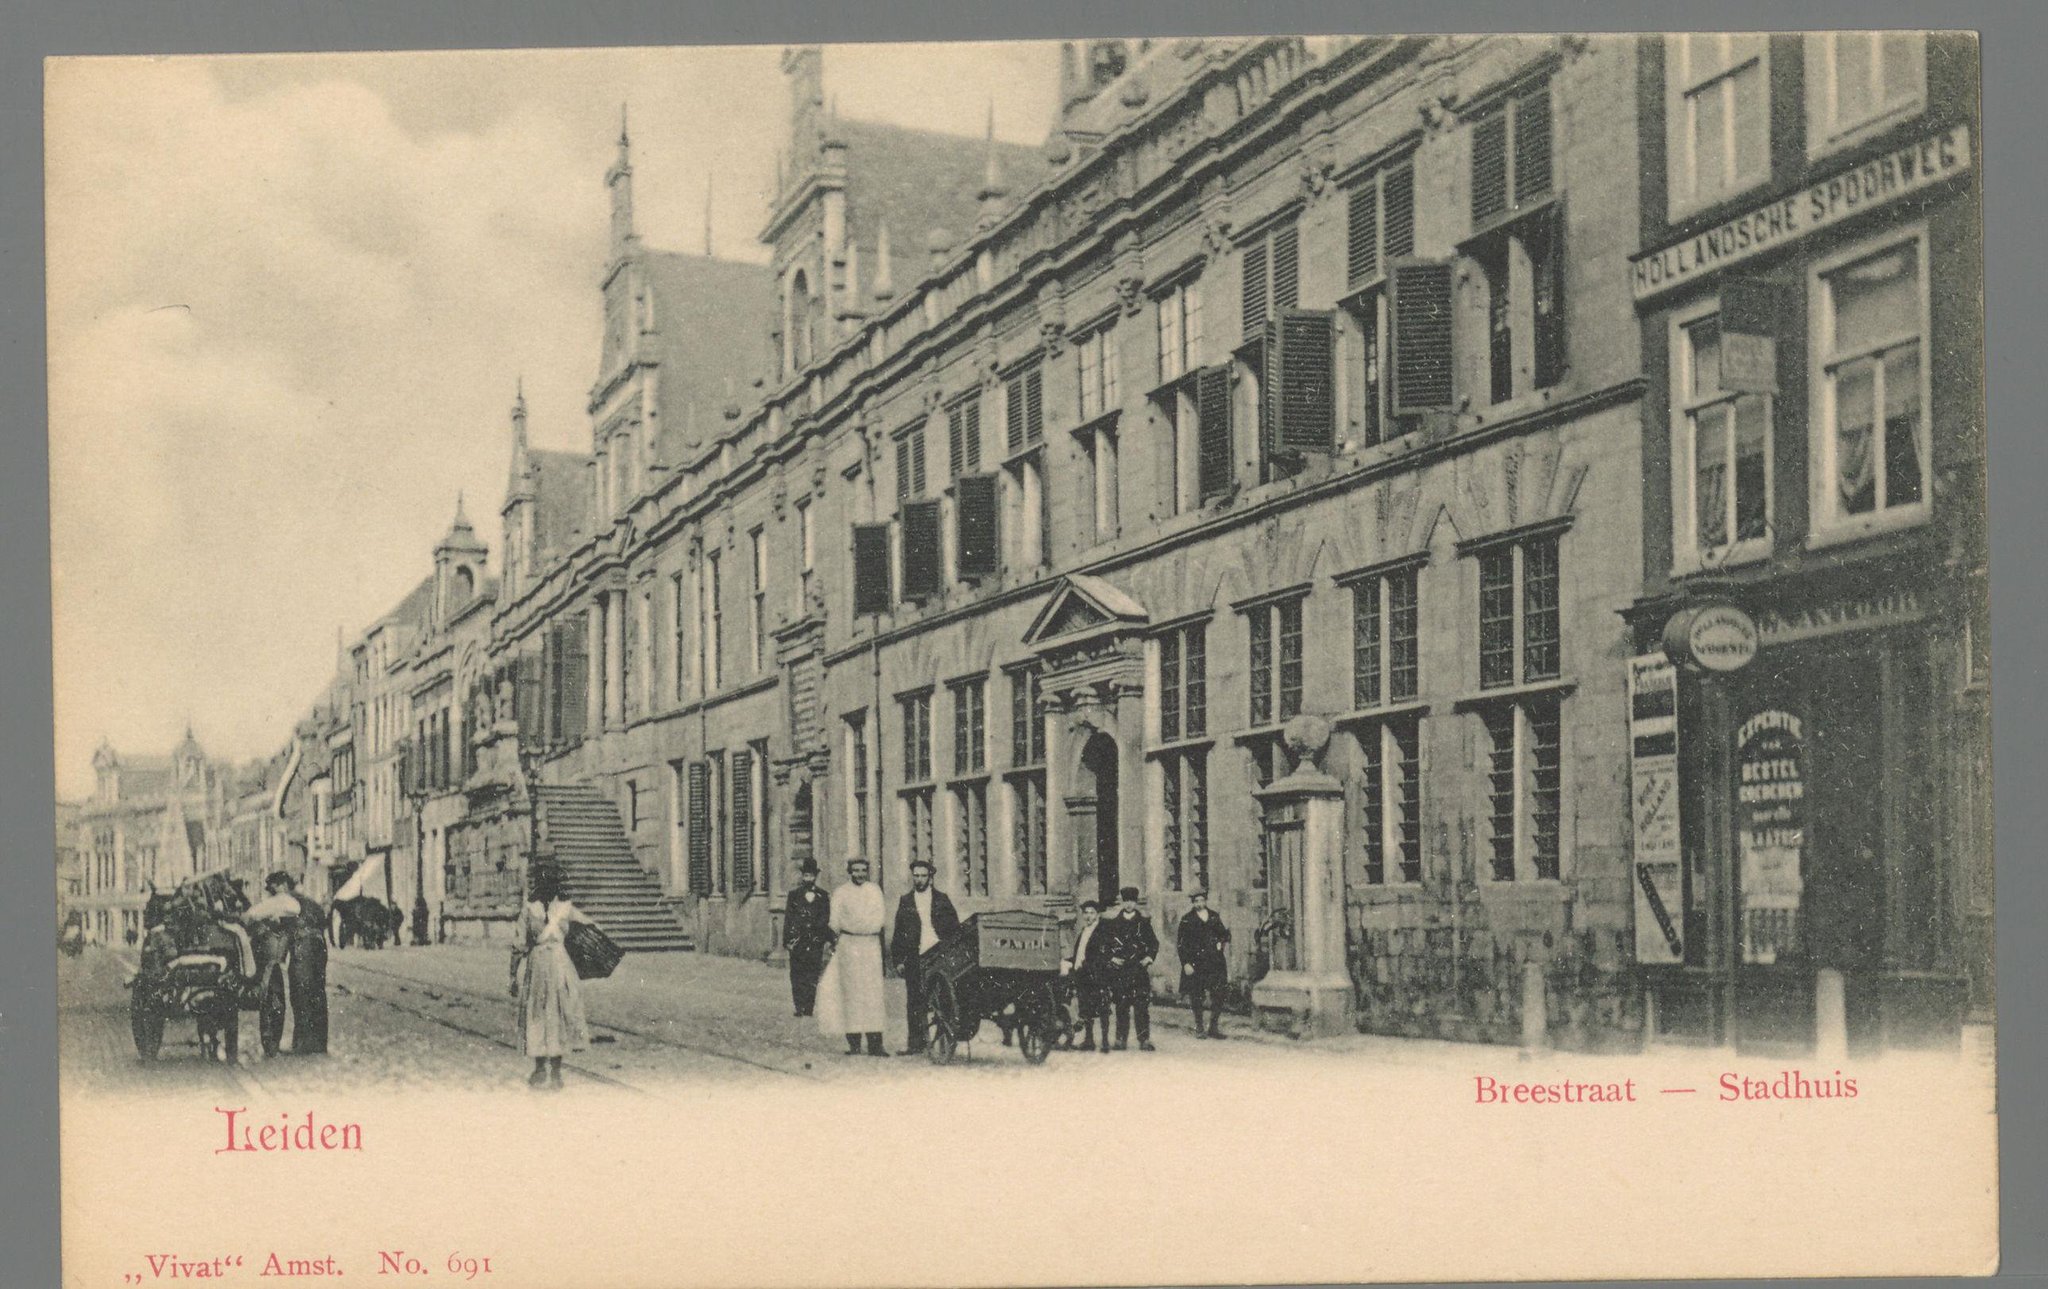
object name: photomechanical print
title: Leiden. Breestraat - Stadhuis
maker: Anonymous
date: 1897-1905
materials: cardboard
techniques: photograph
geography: amsterdam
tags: townhall, street